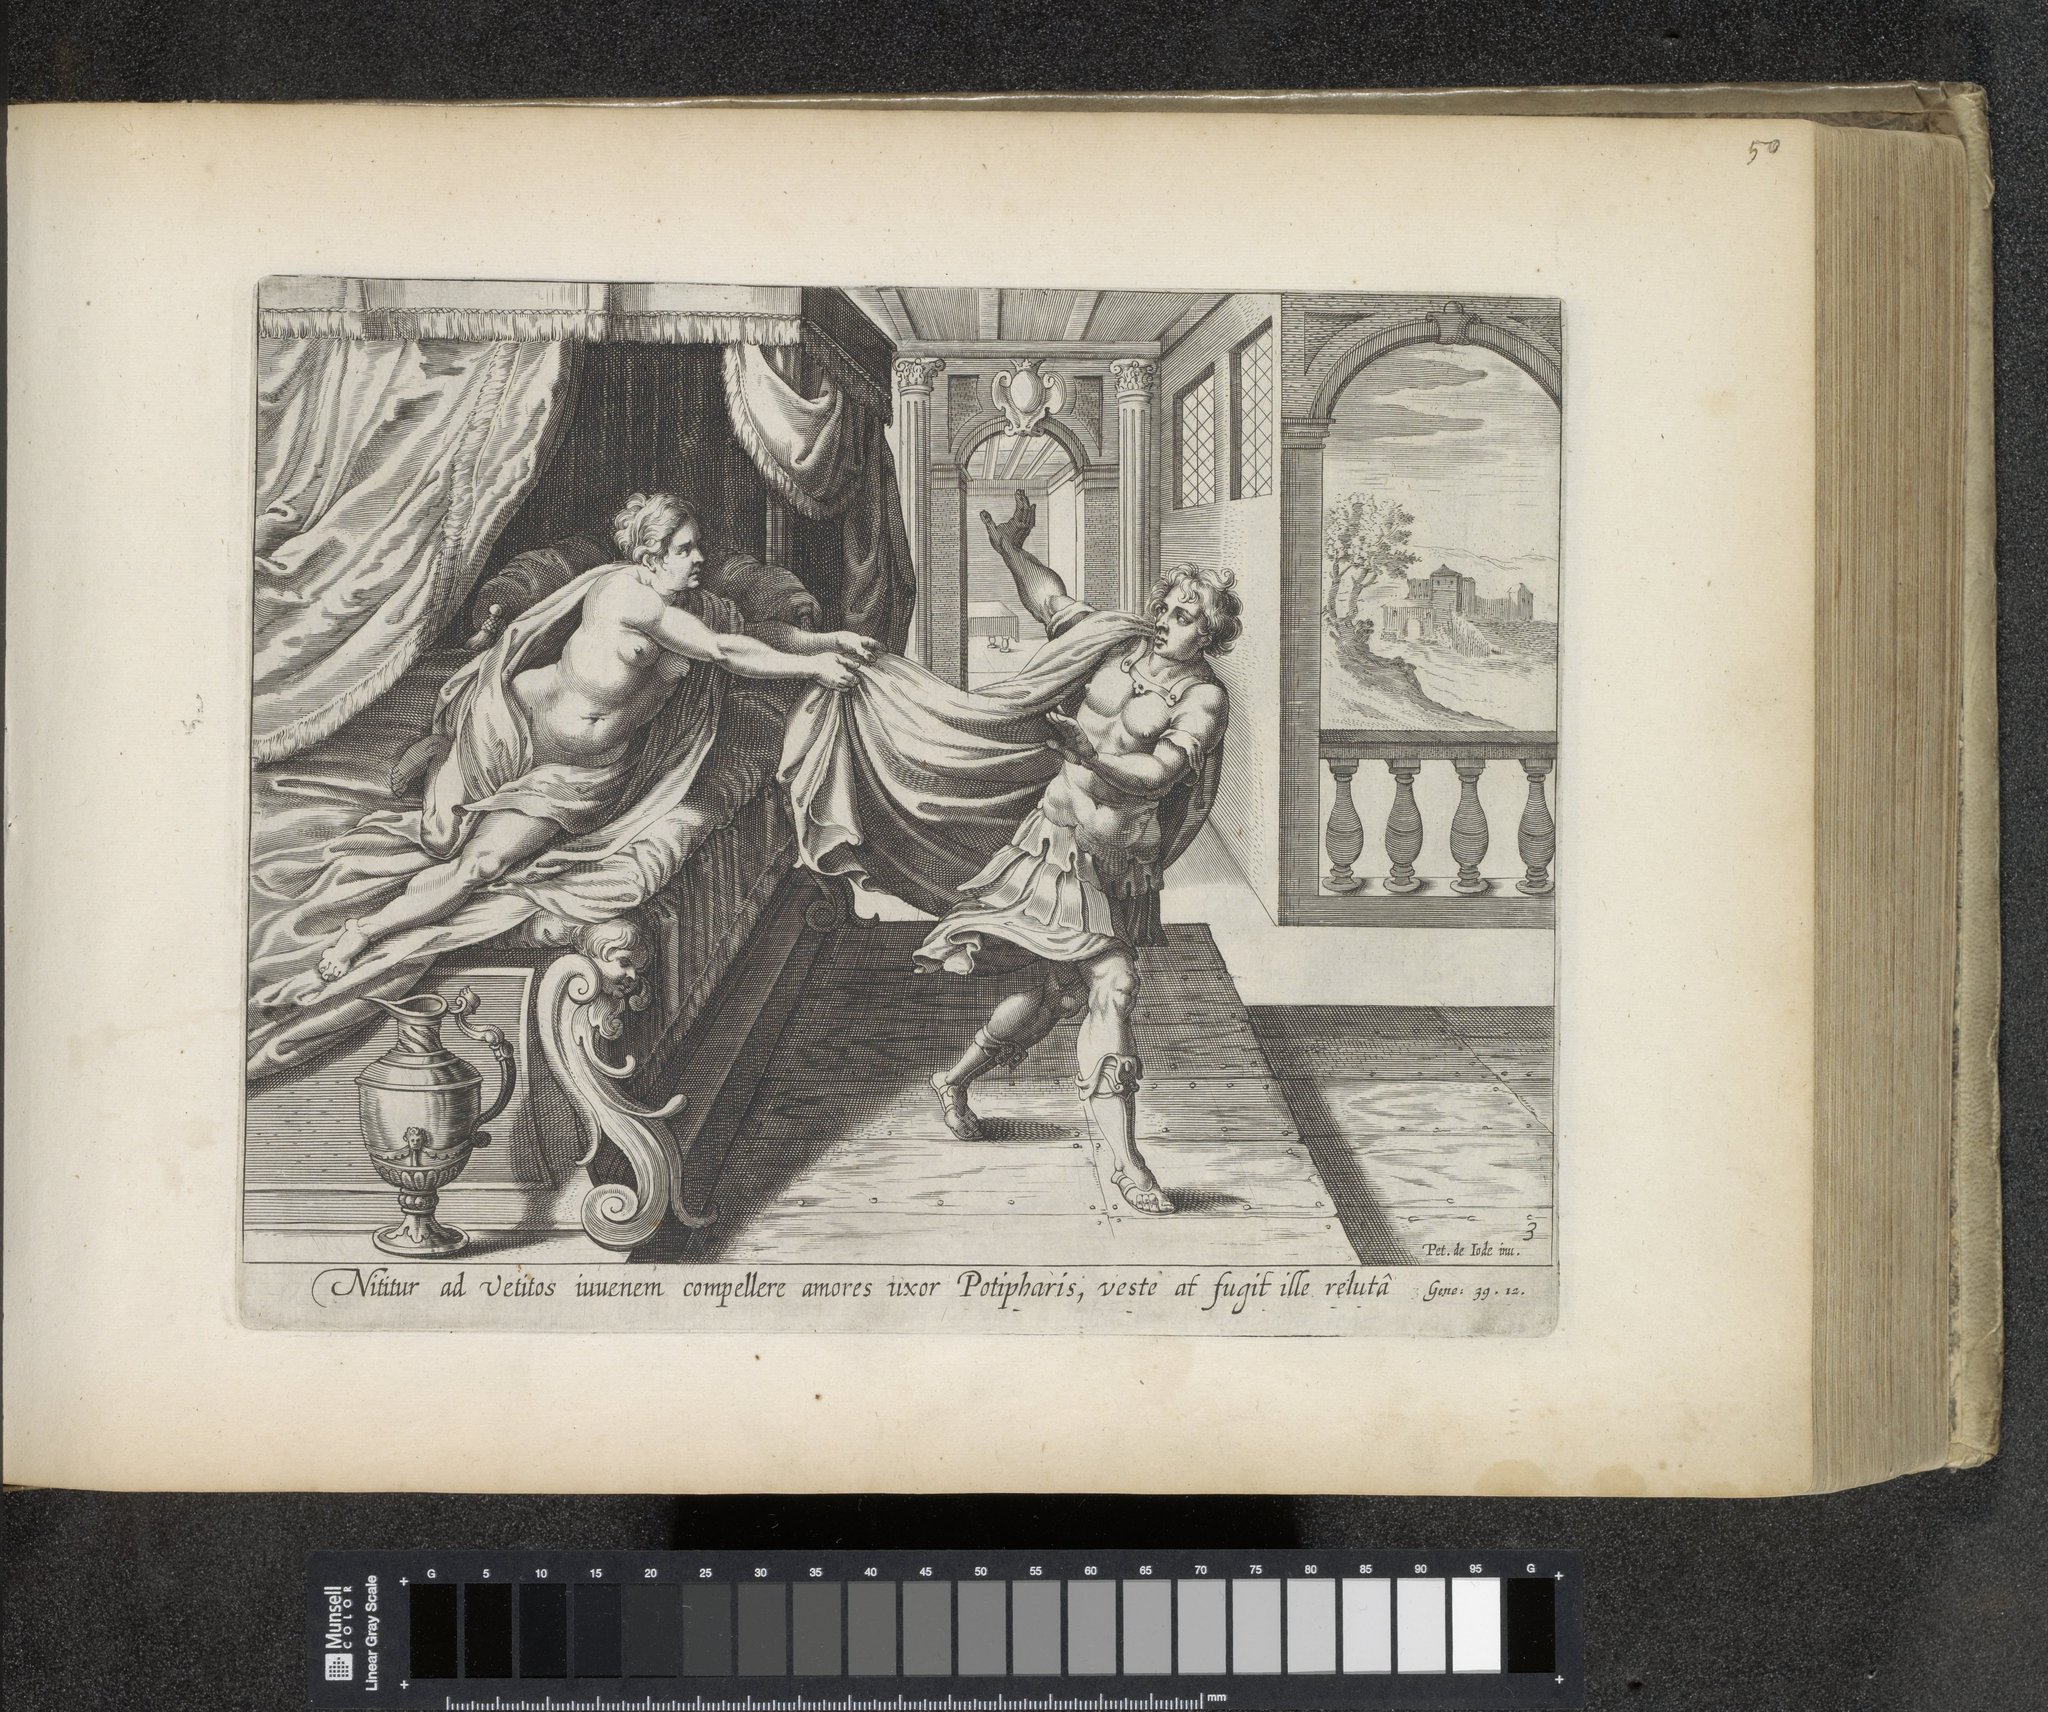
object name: print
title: Theatrum Biblicum Hoc Est Historiae Sacrae Veteris et Novi Testamenti Tabulis Aeneis Expressae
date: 1643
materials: paper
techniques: engraving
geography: amsterdam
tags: potiphar's wife catches joseph by his robe, usually while lying in bed; joseph escapes leaving his cloak behind in her hands (possibly with a naked child lying in a crib)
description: Jozef vlucht voor de vrouw van Potifar, die in bed ligt en hem probeert te verleiden. Zij grijpt zijn kleed vast. Onder de voorstelling een verwijzing in het Latijn naar de Bijbeltekst in Gen. 39:12. Deze prent maakt deel uit van een album.